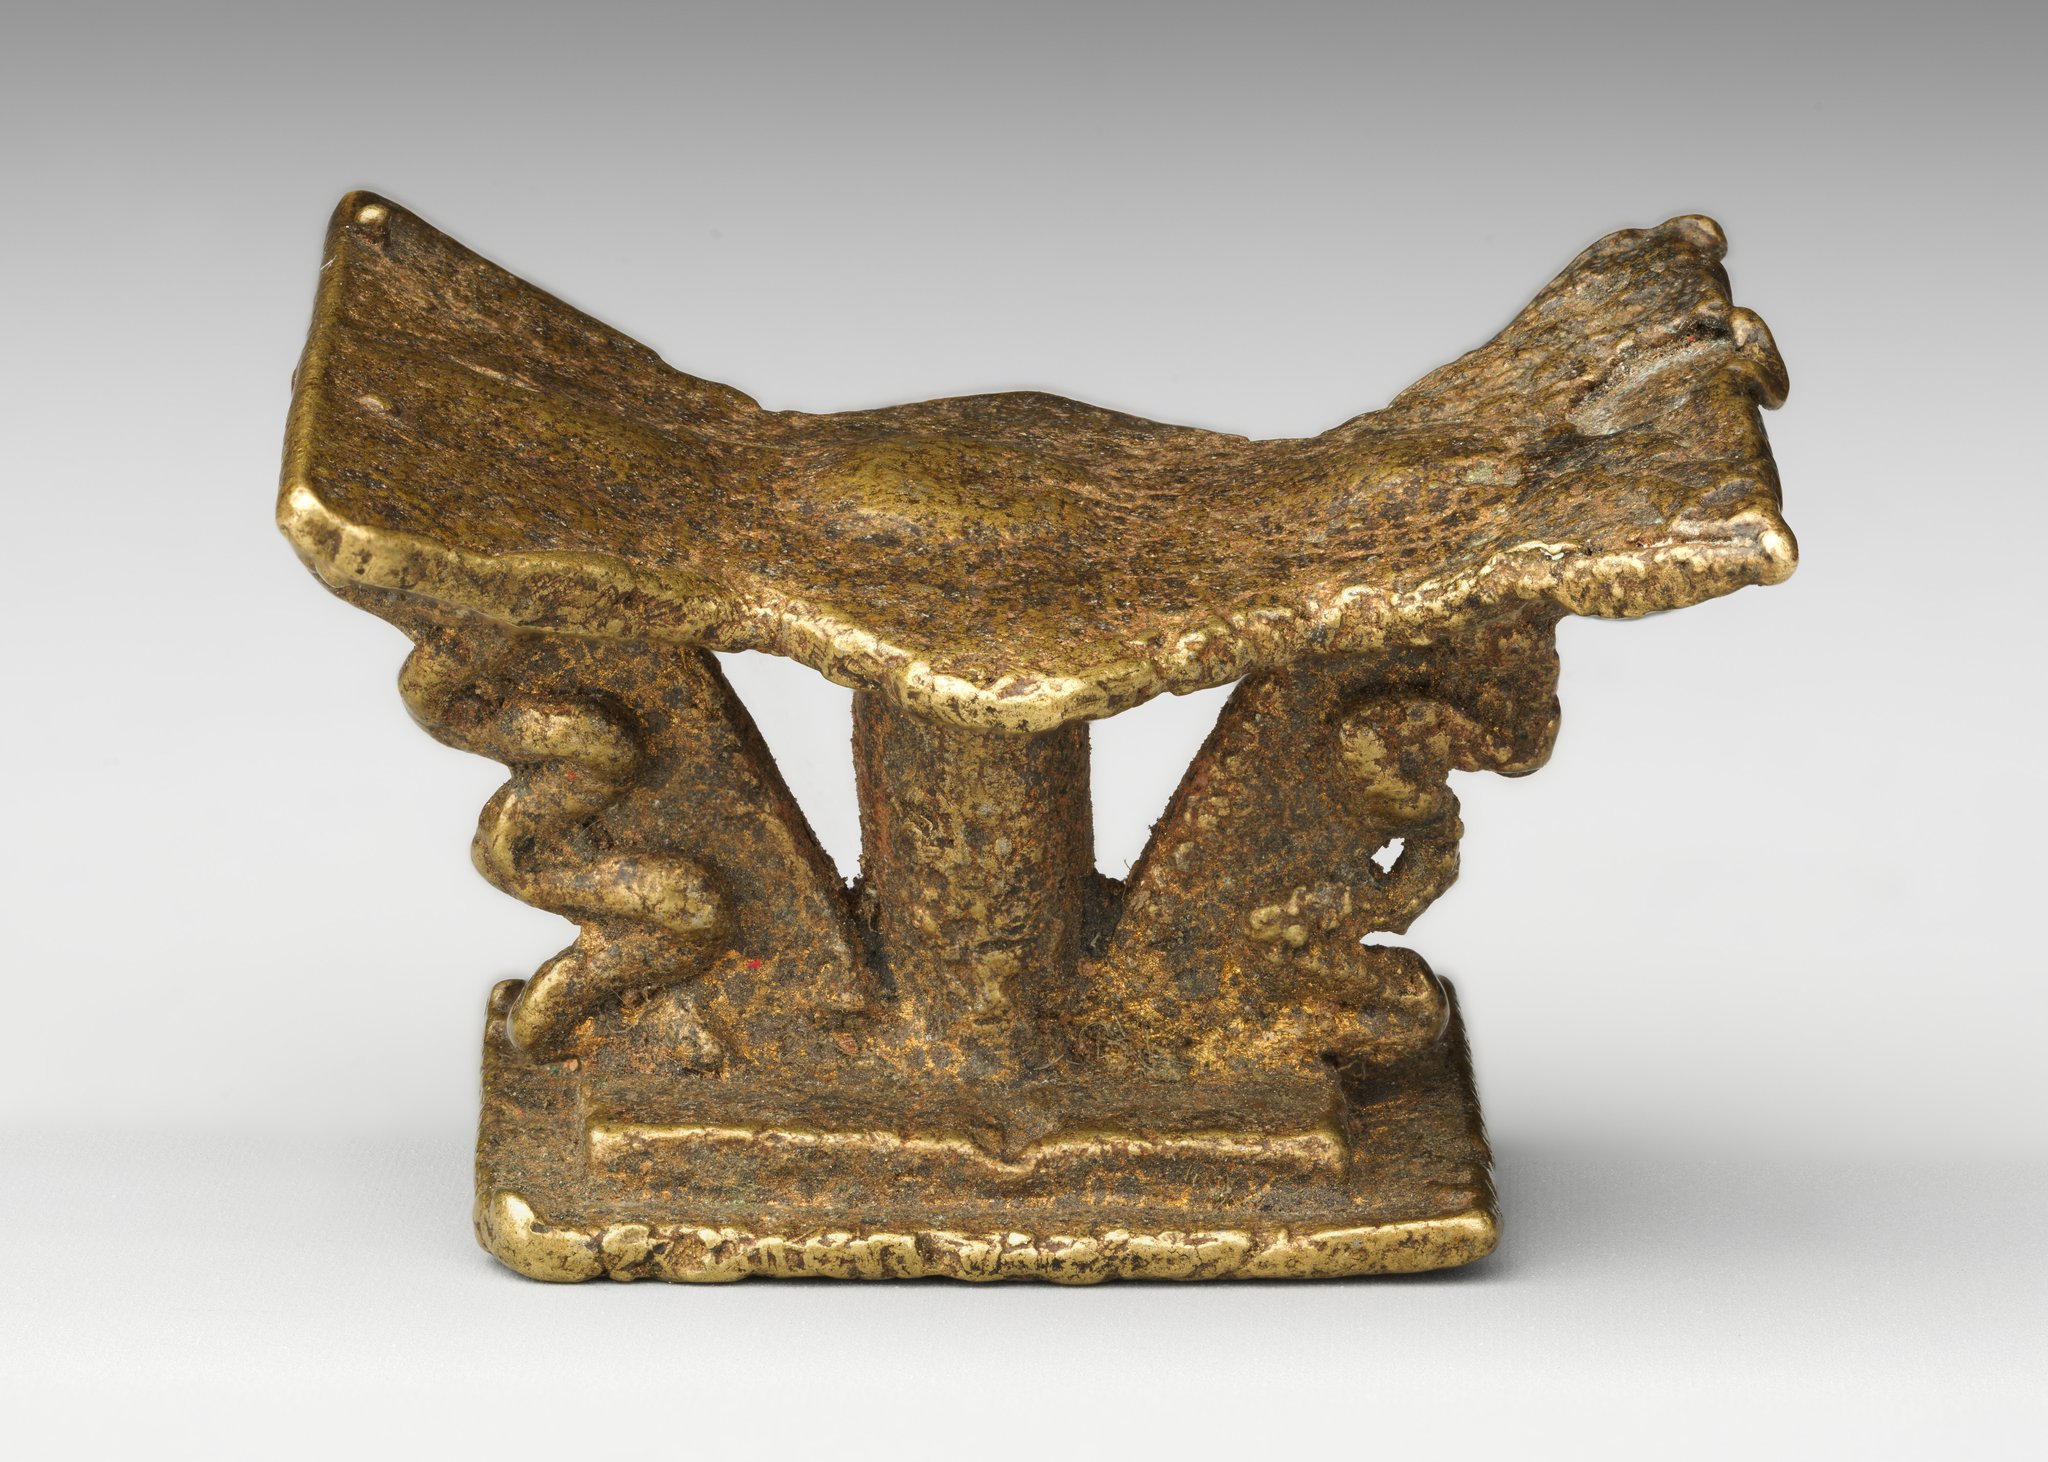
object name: weight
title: Stool gold weight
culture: akan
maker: akan artist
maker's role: artist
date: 1701-1900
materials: brass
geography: côte d’ivoire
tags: stools